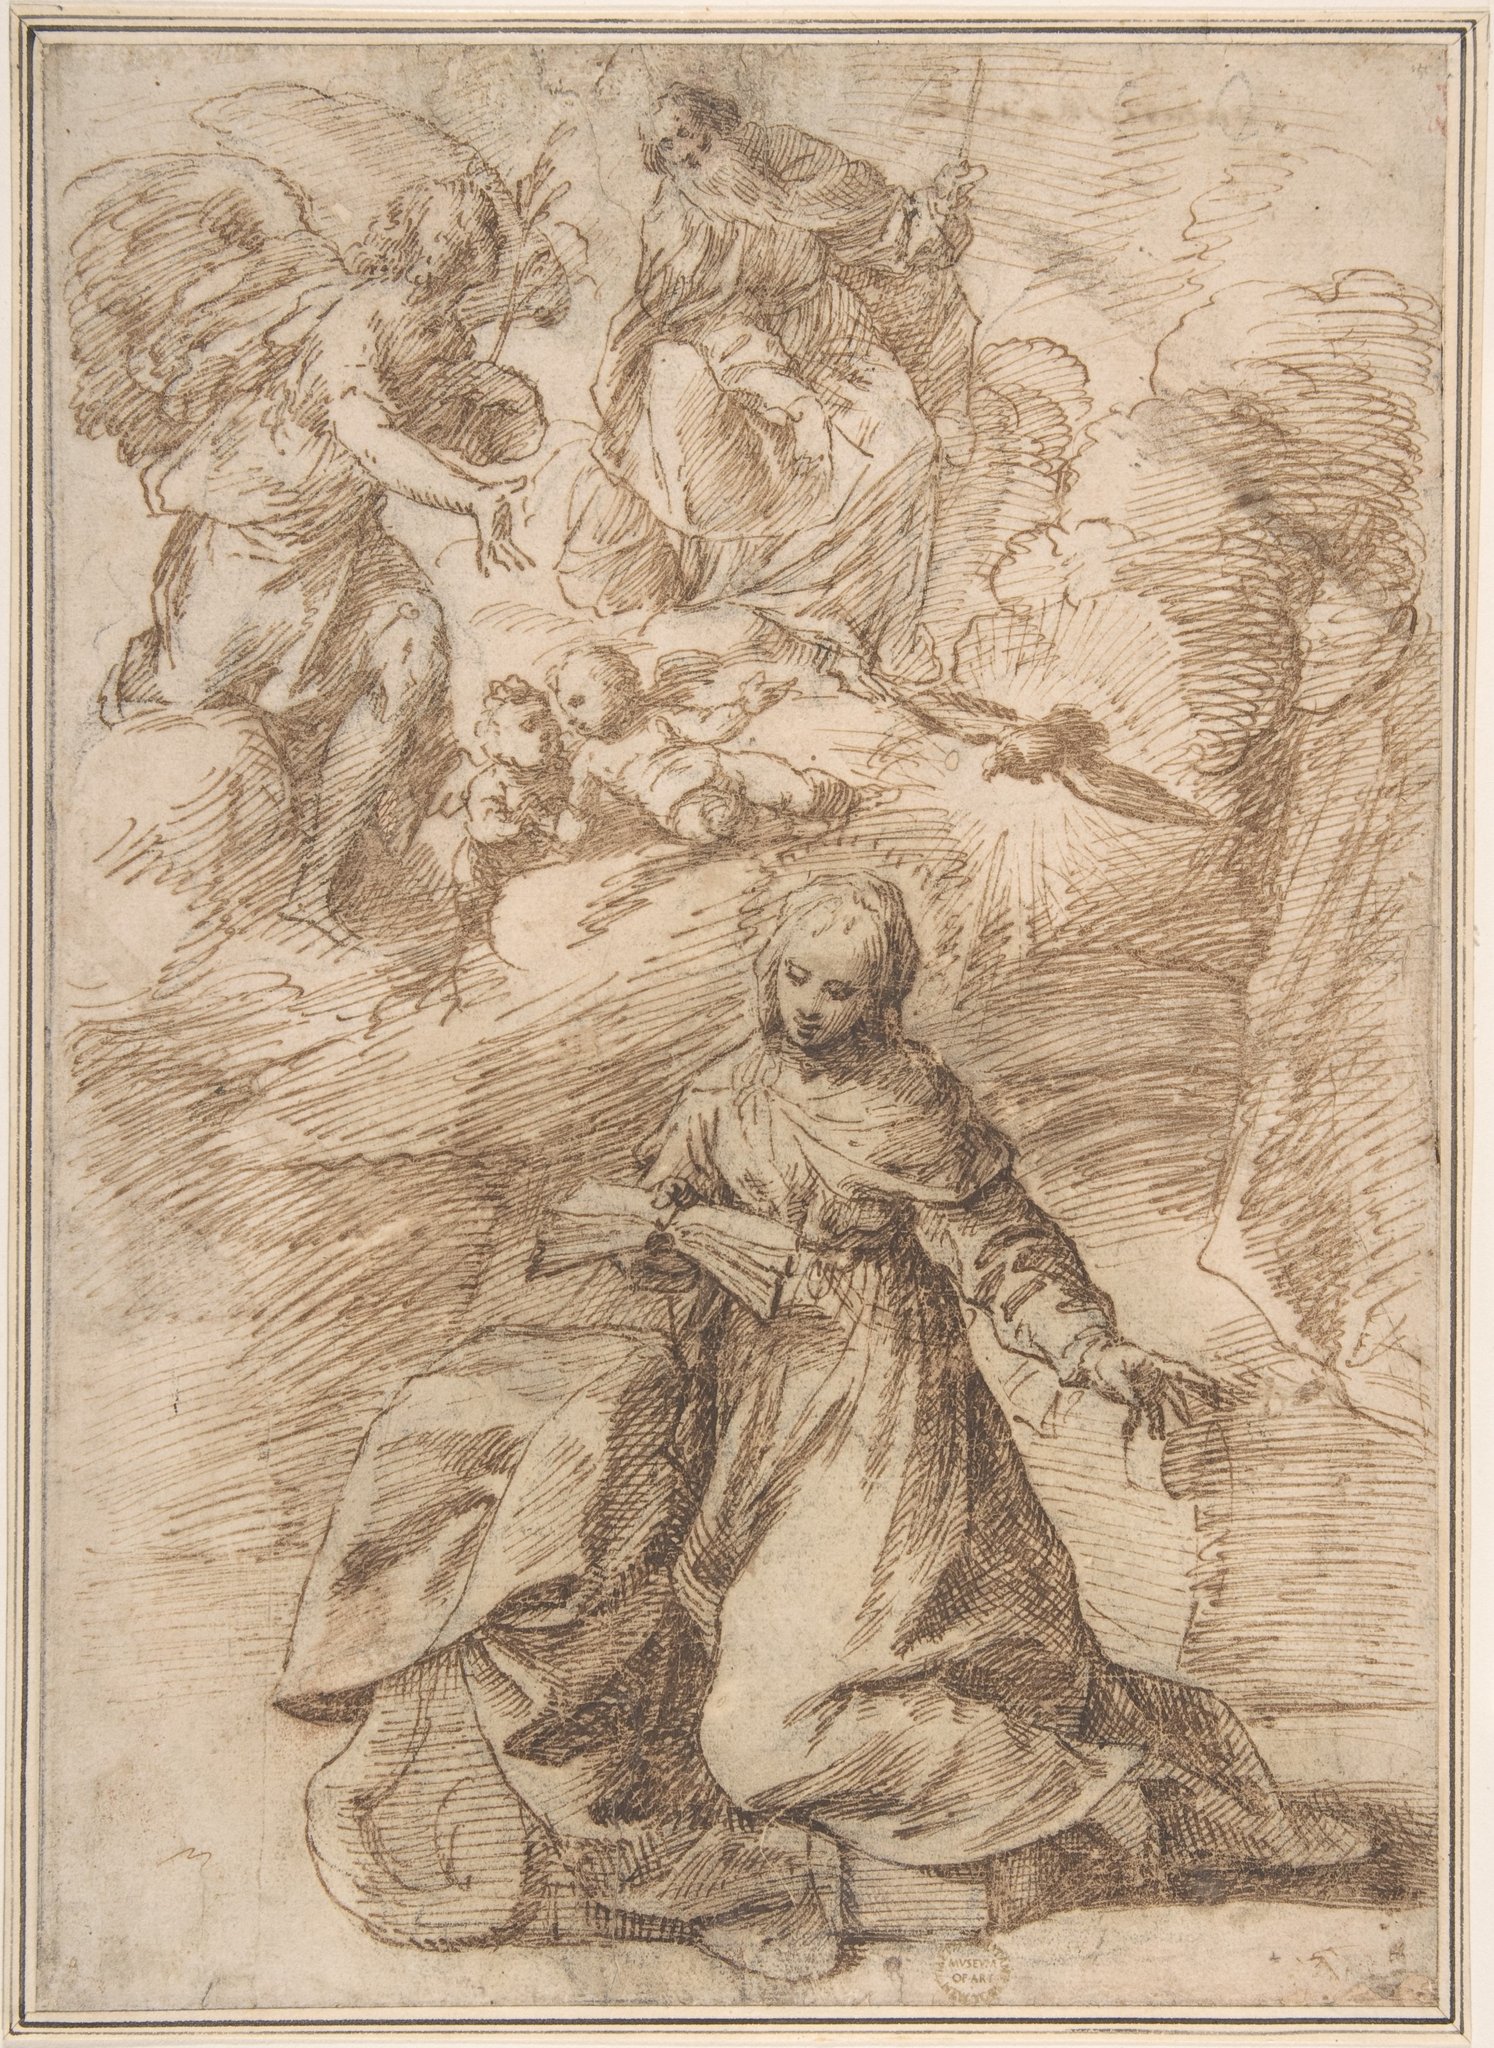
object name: drawing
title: Annunciation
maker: anonymous, italian, 17th century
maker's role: artist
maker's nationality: italian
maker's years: 1600-1700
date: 1601-1700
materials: ink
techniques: pen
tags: birds,women,cupid,angels,annunciation